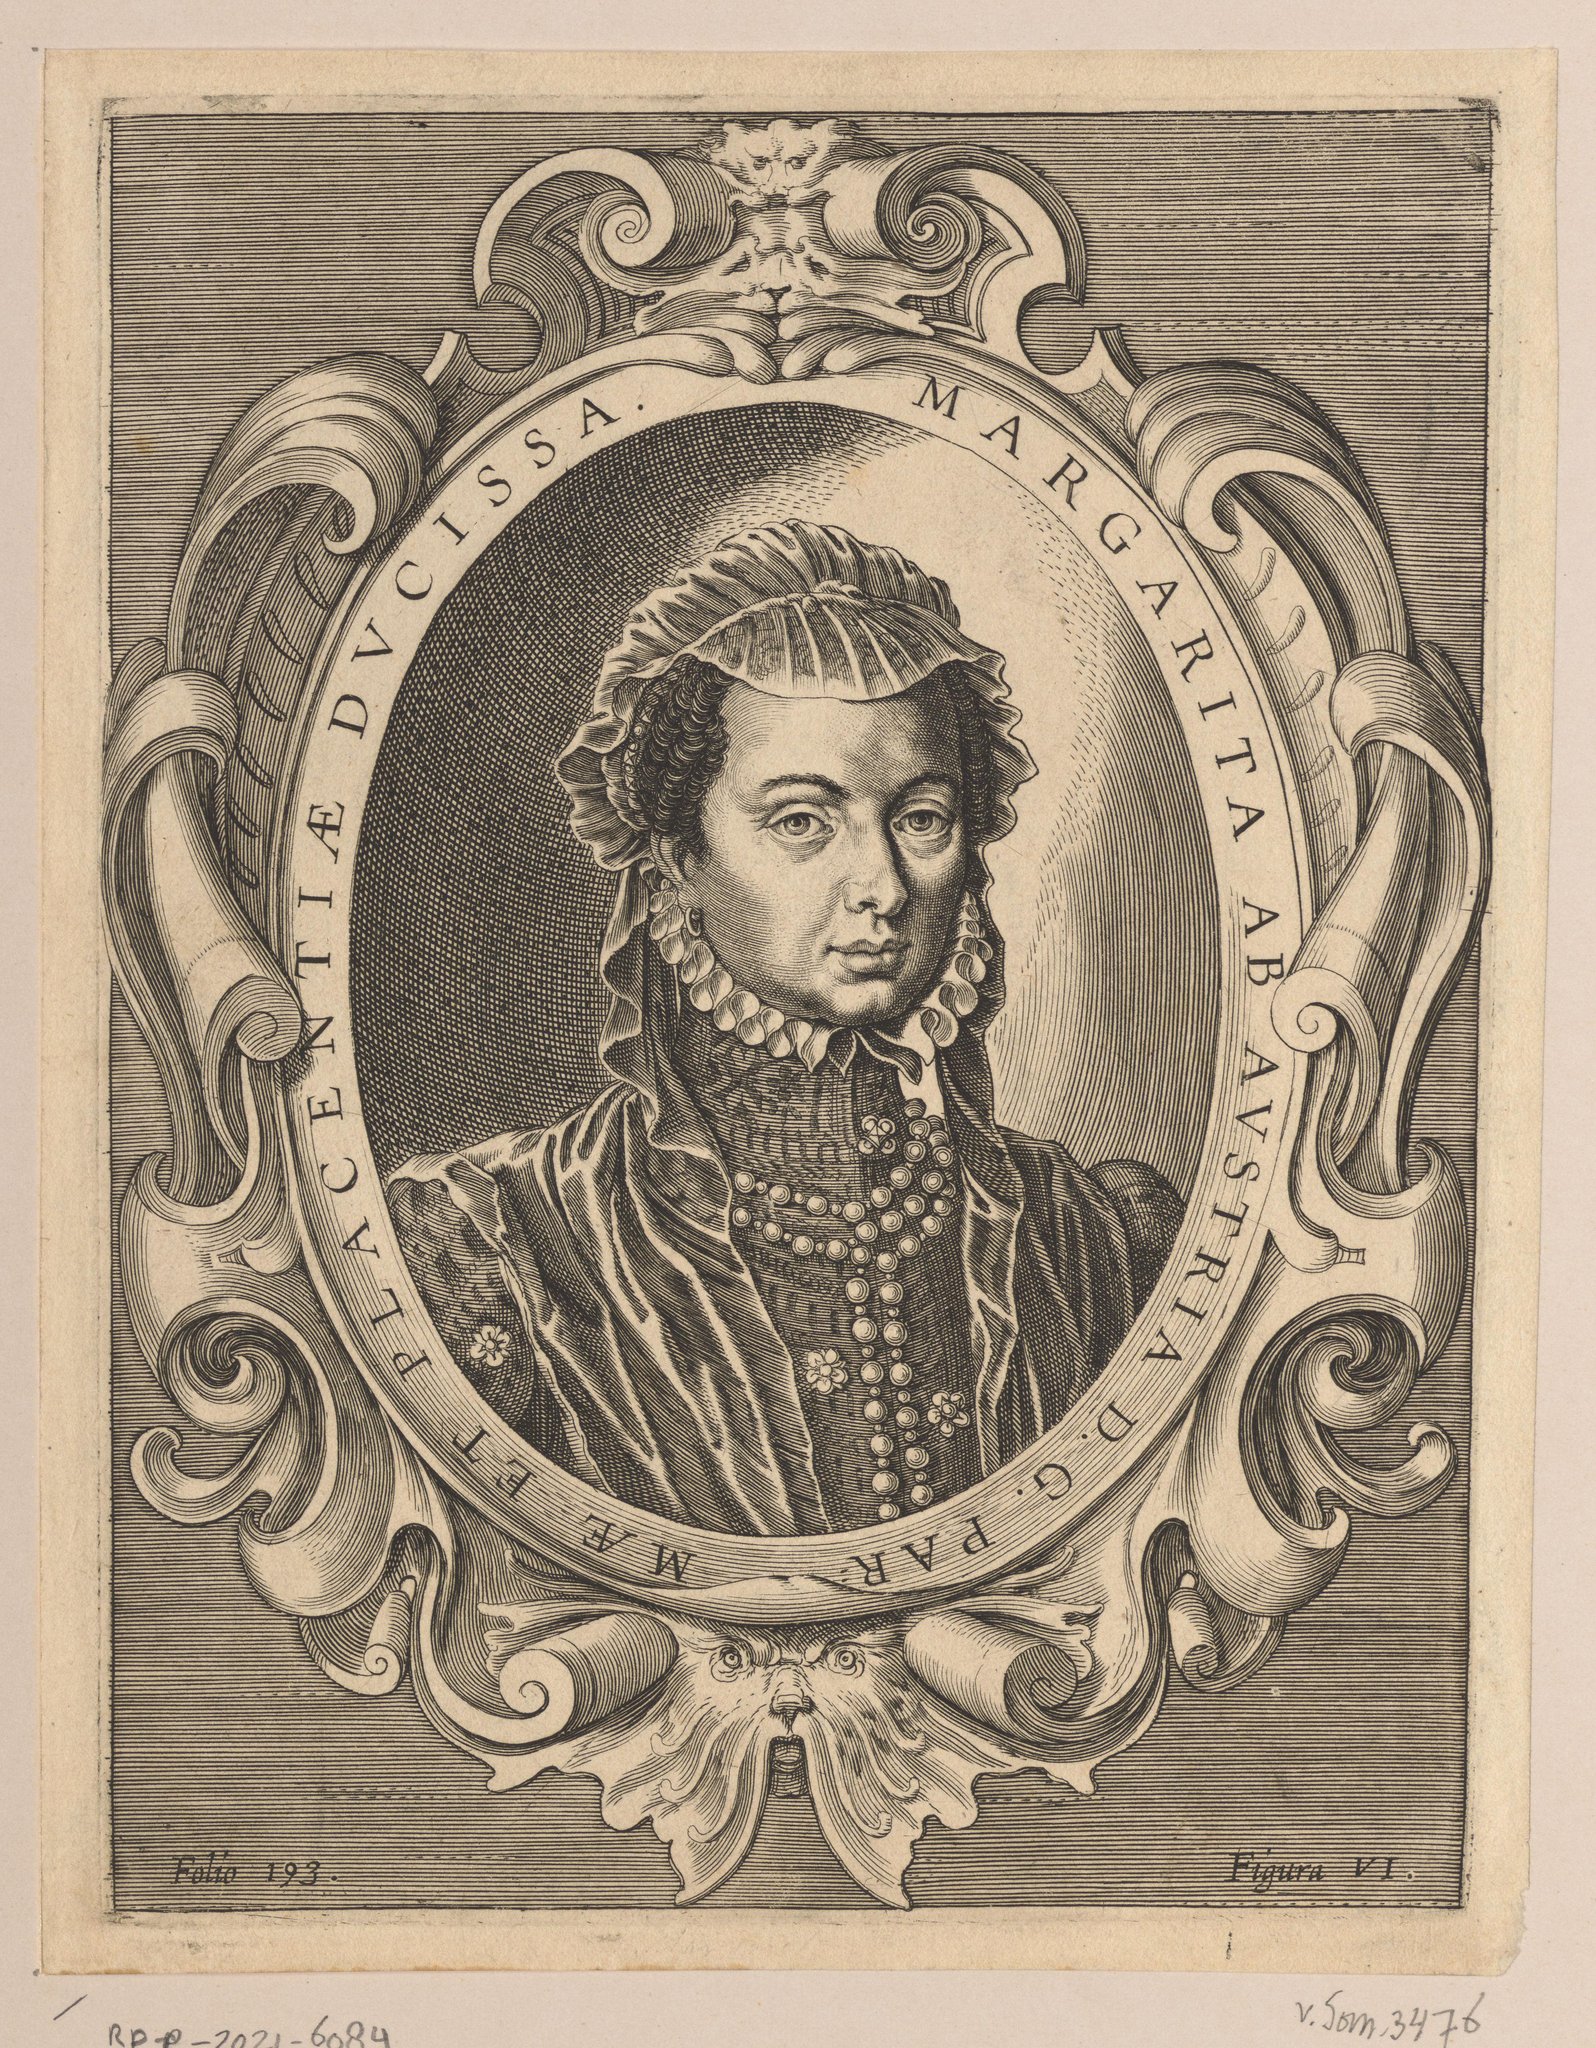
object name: book illustration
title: Portret van Margaretha van Parma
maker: Anonymous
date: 1620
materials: paper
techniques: engraving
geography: southern netherlands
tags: historical persons - bb - woman, ornament ~ medallion, ornament derived from architectural details, regent, substitute ruler; viceroy - bb - female ruler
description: Prent waarschijnlijk uit: Meerbeeck, Adriaen van. Chroniicke van de Gantsche Werelt, ende sonderlinghe vande Seventhien Nederlanden (...). Antwerpen: Hieronymus Verdussen, 1620.